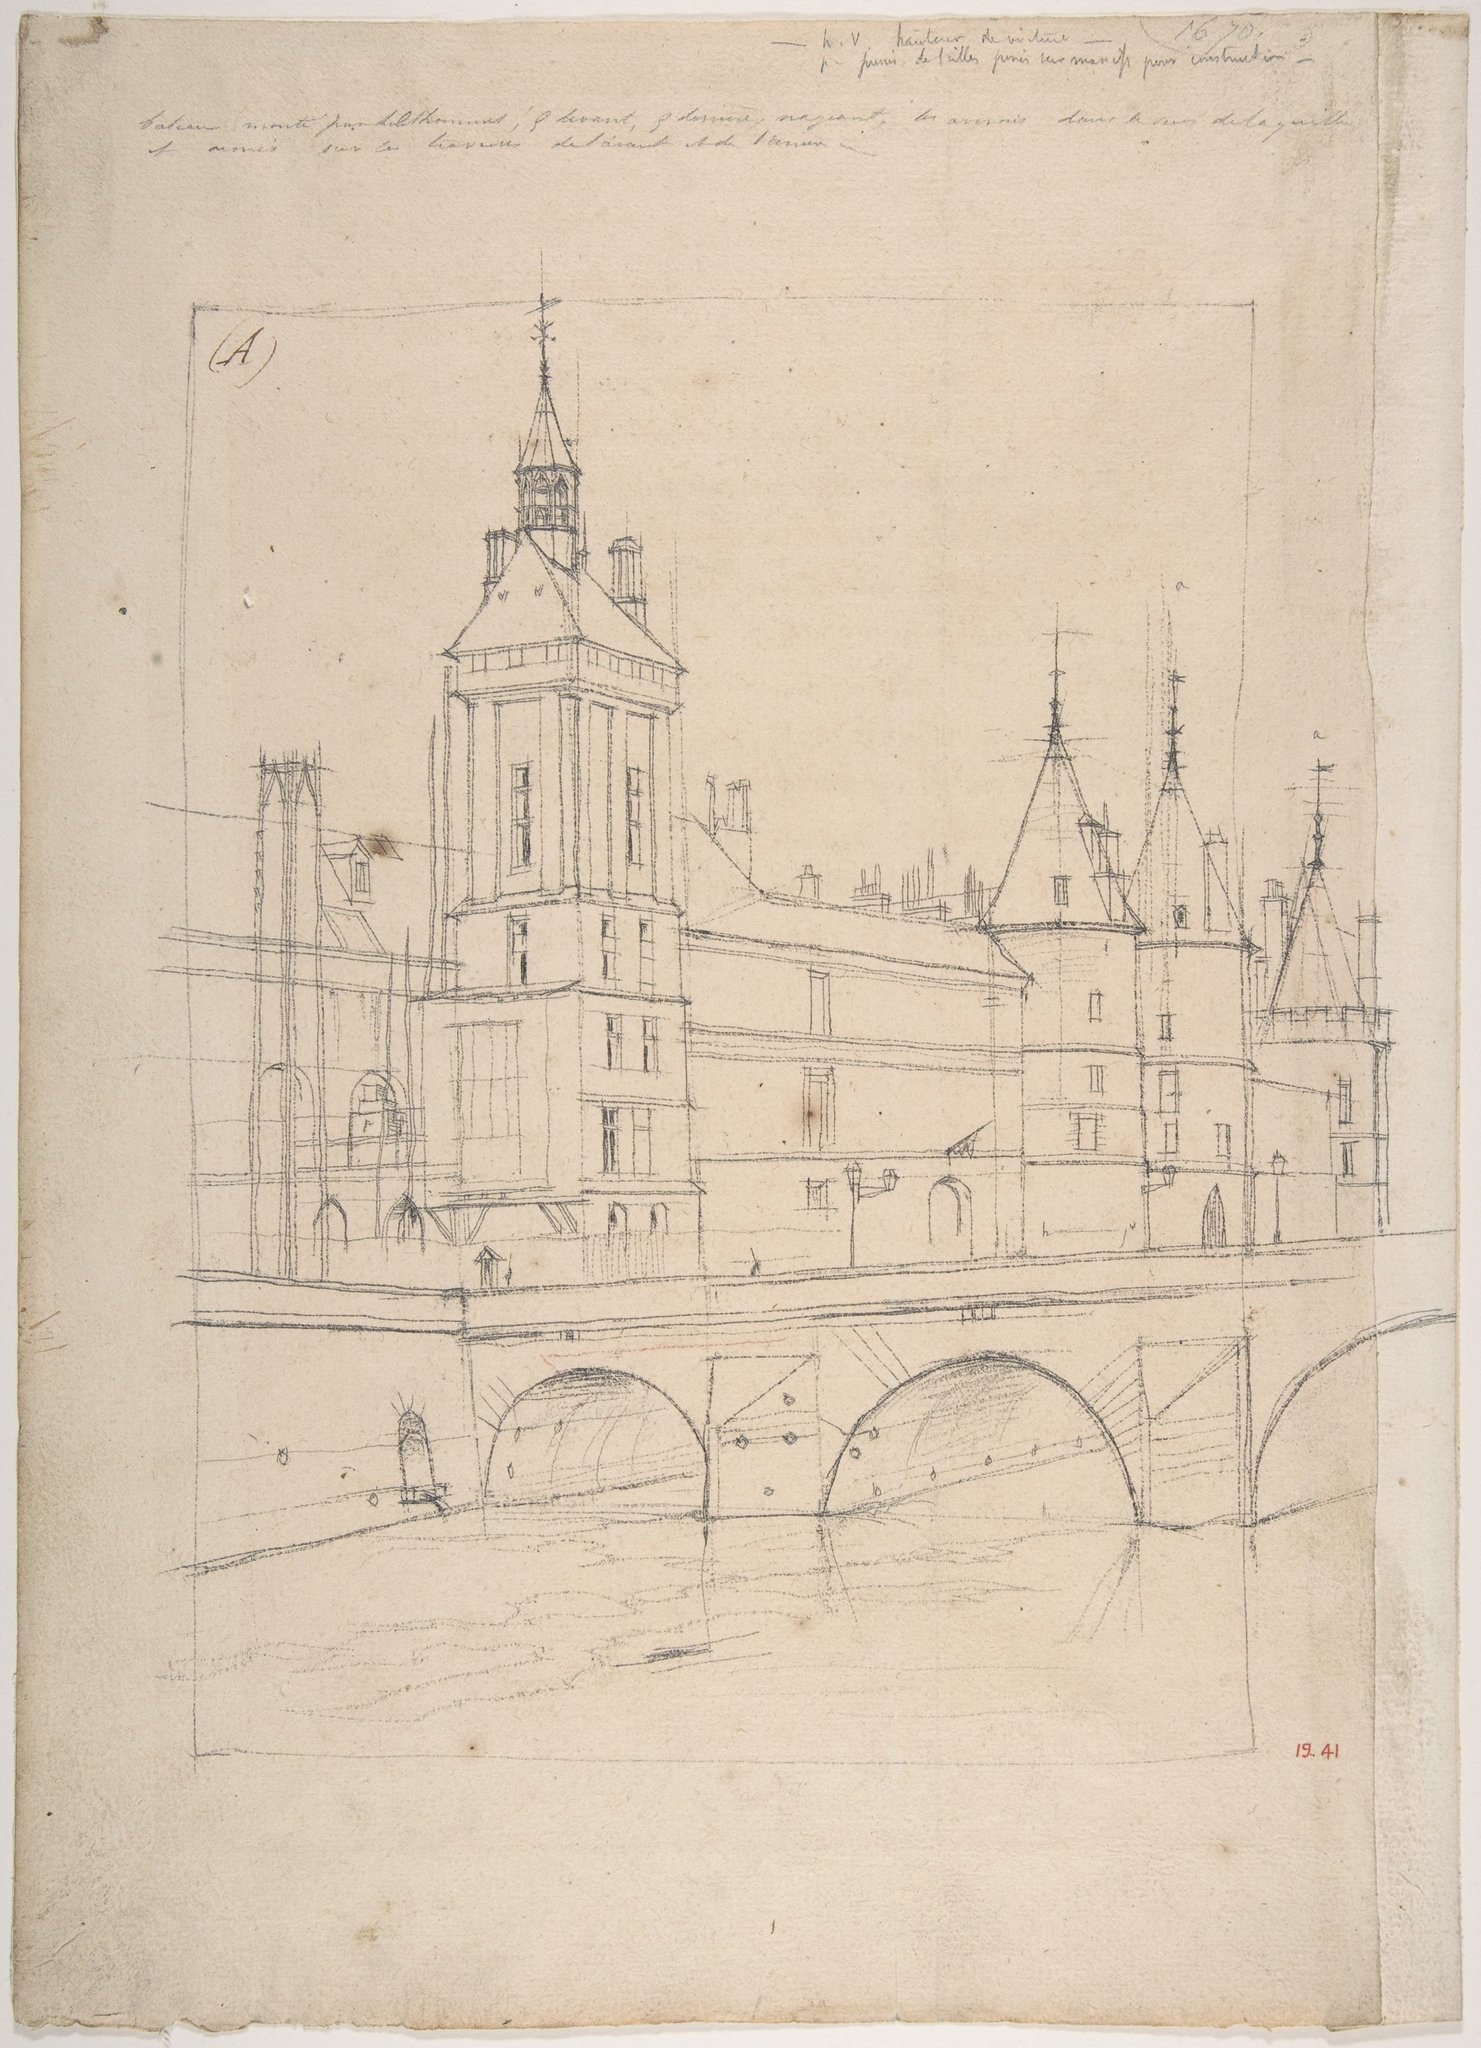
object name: drawing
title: The Clock Tower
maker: charles meryon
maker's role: artist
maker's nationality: french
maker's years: 1821-1868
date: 1852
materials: chalk, graphite, paper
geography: france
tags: towers,bridges